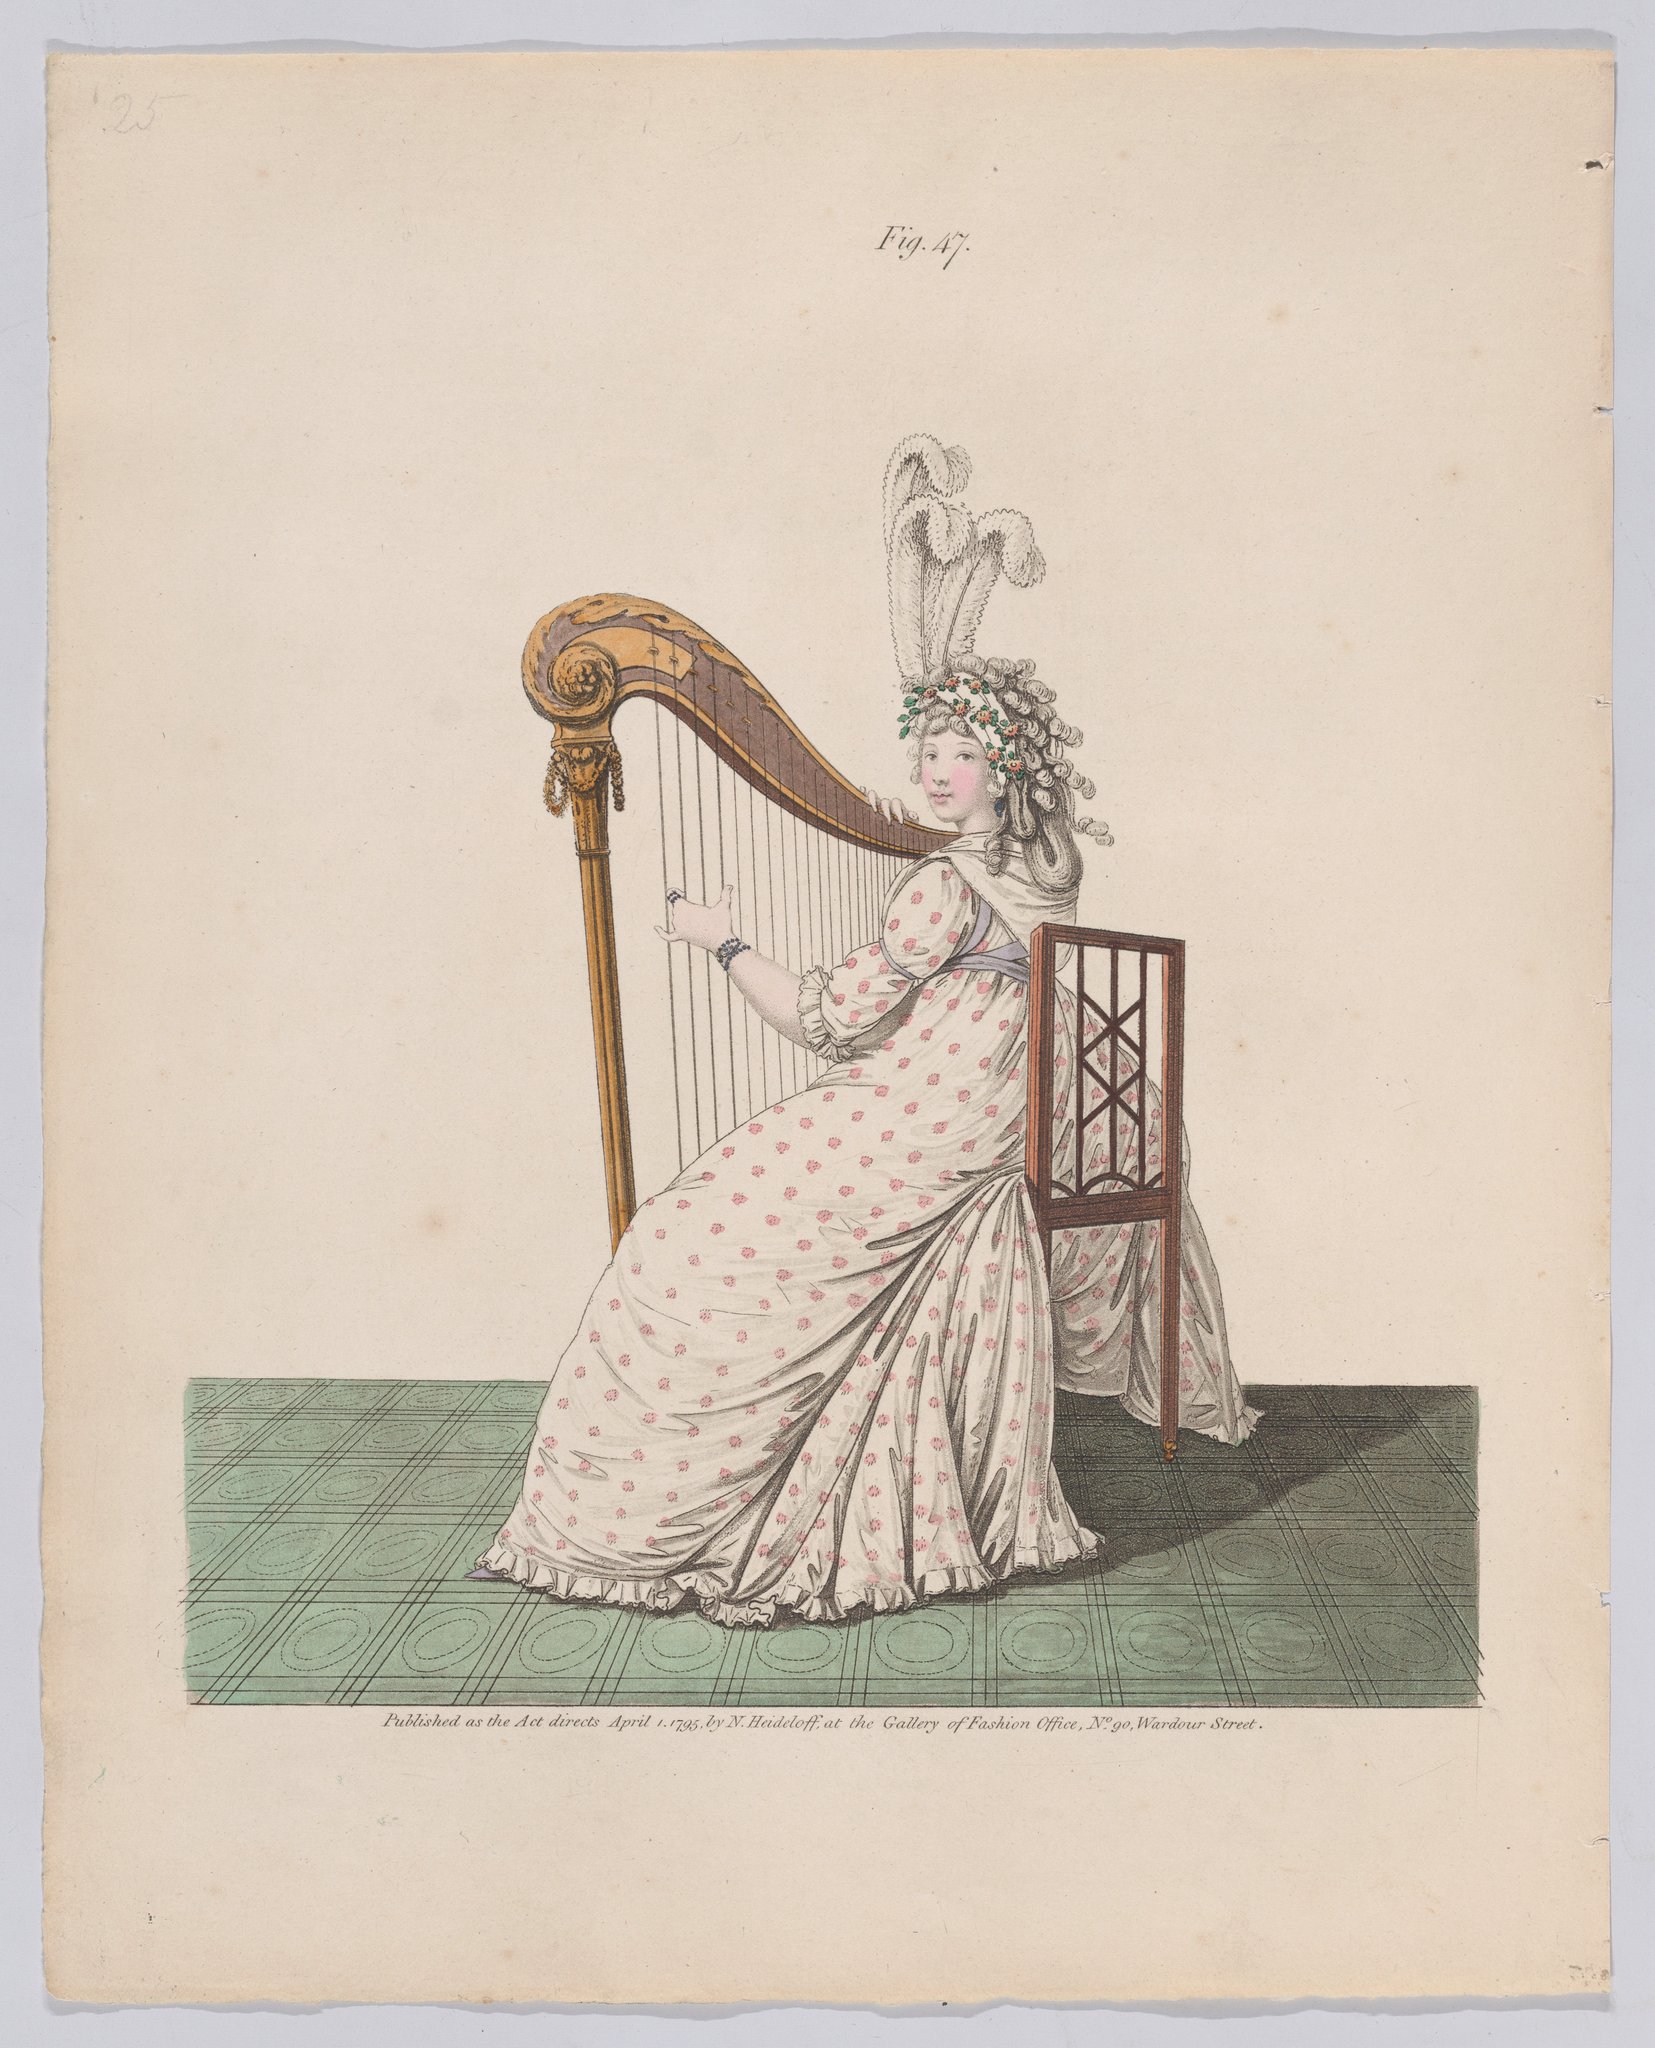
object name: book costume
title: Gallery of Fashion, vol.II: April 1 1795 - March 1, 1796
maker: nicolaus heideloff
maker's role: publisher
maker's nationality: british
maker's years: 1761-1837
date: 1794-1802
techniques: engraving, etching, hand coloring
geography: england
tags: women,harps,fashion